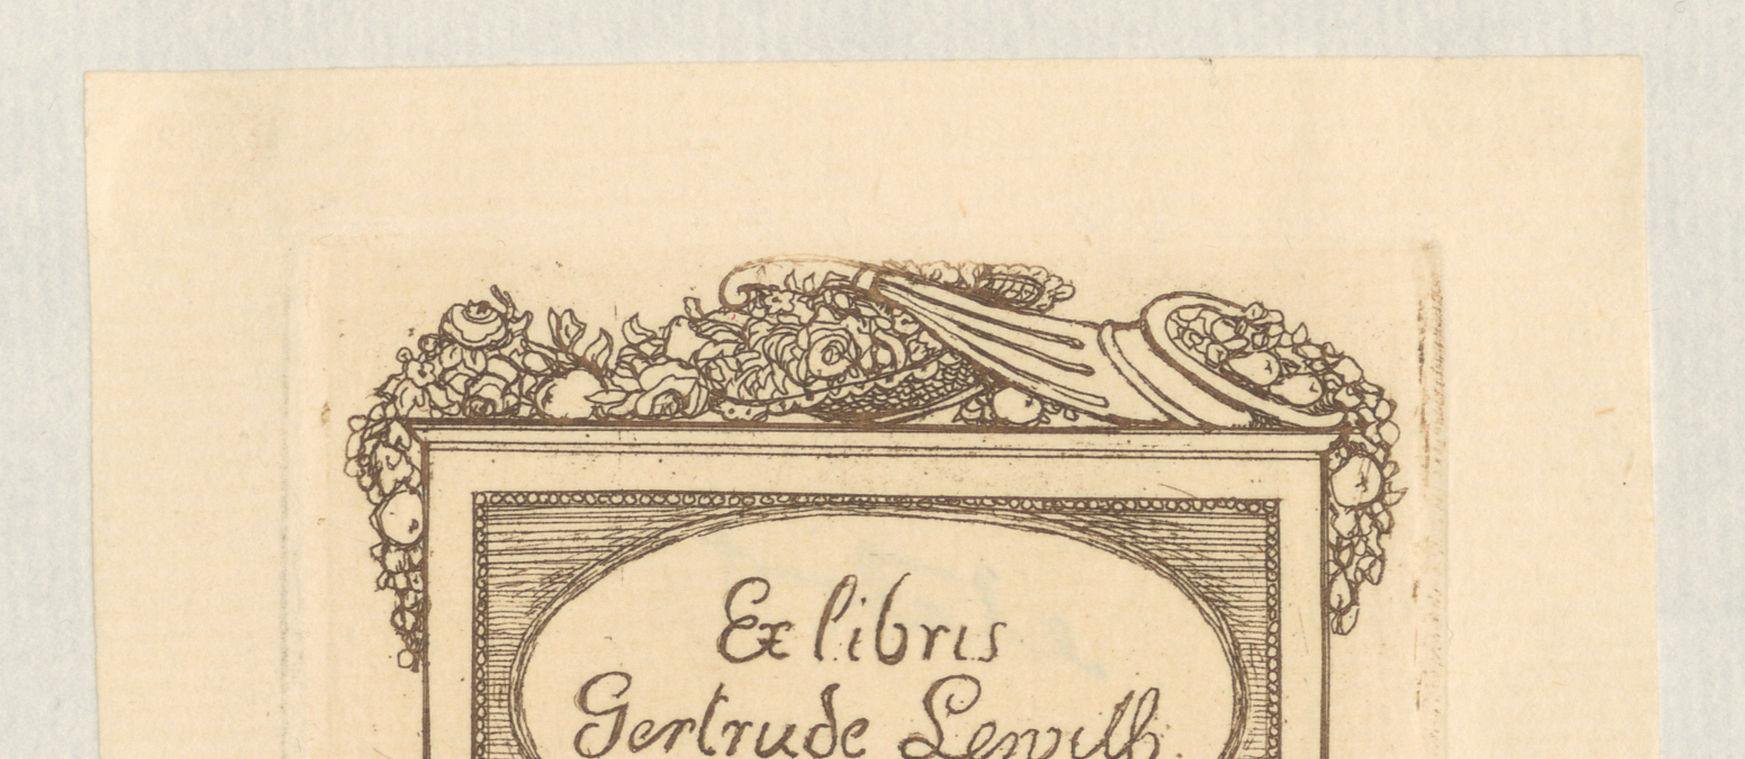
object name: bookplate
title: Ex libris van Gertrude Lenvilh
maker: Anonymous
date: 1800-1899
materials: paper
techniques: etching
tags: 'cornucopia', horn of plenty